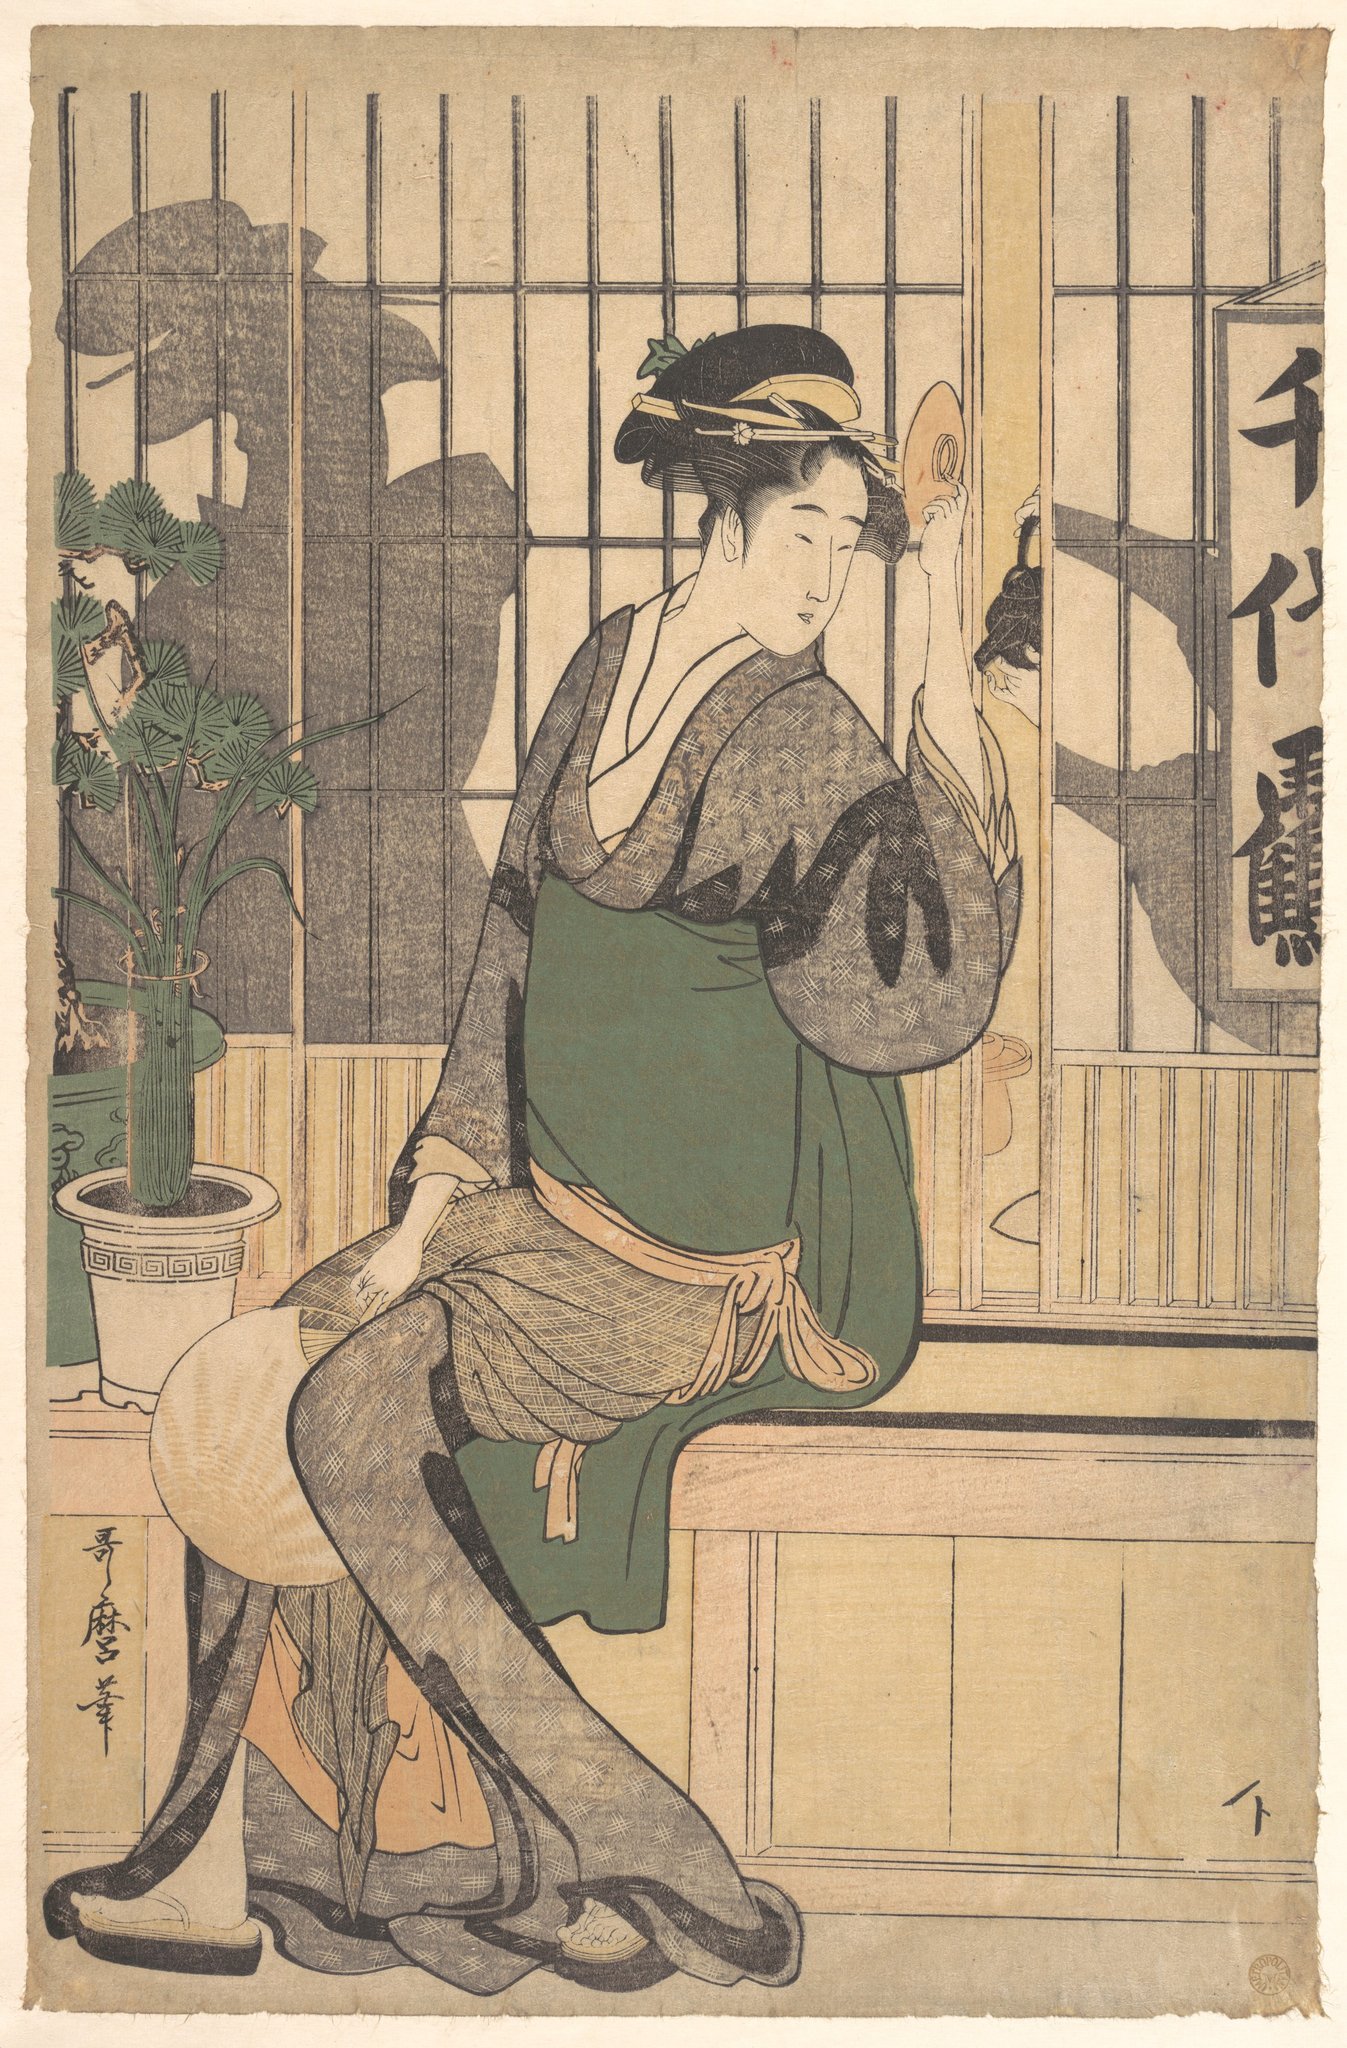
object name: print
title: Shadows on the Shoji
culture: japanese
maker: kitagawa utamaro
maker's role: artist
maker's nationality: japanese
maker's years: 1754-1806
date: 1790-1799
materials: ink, paper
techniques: woodblock print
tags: women